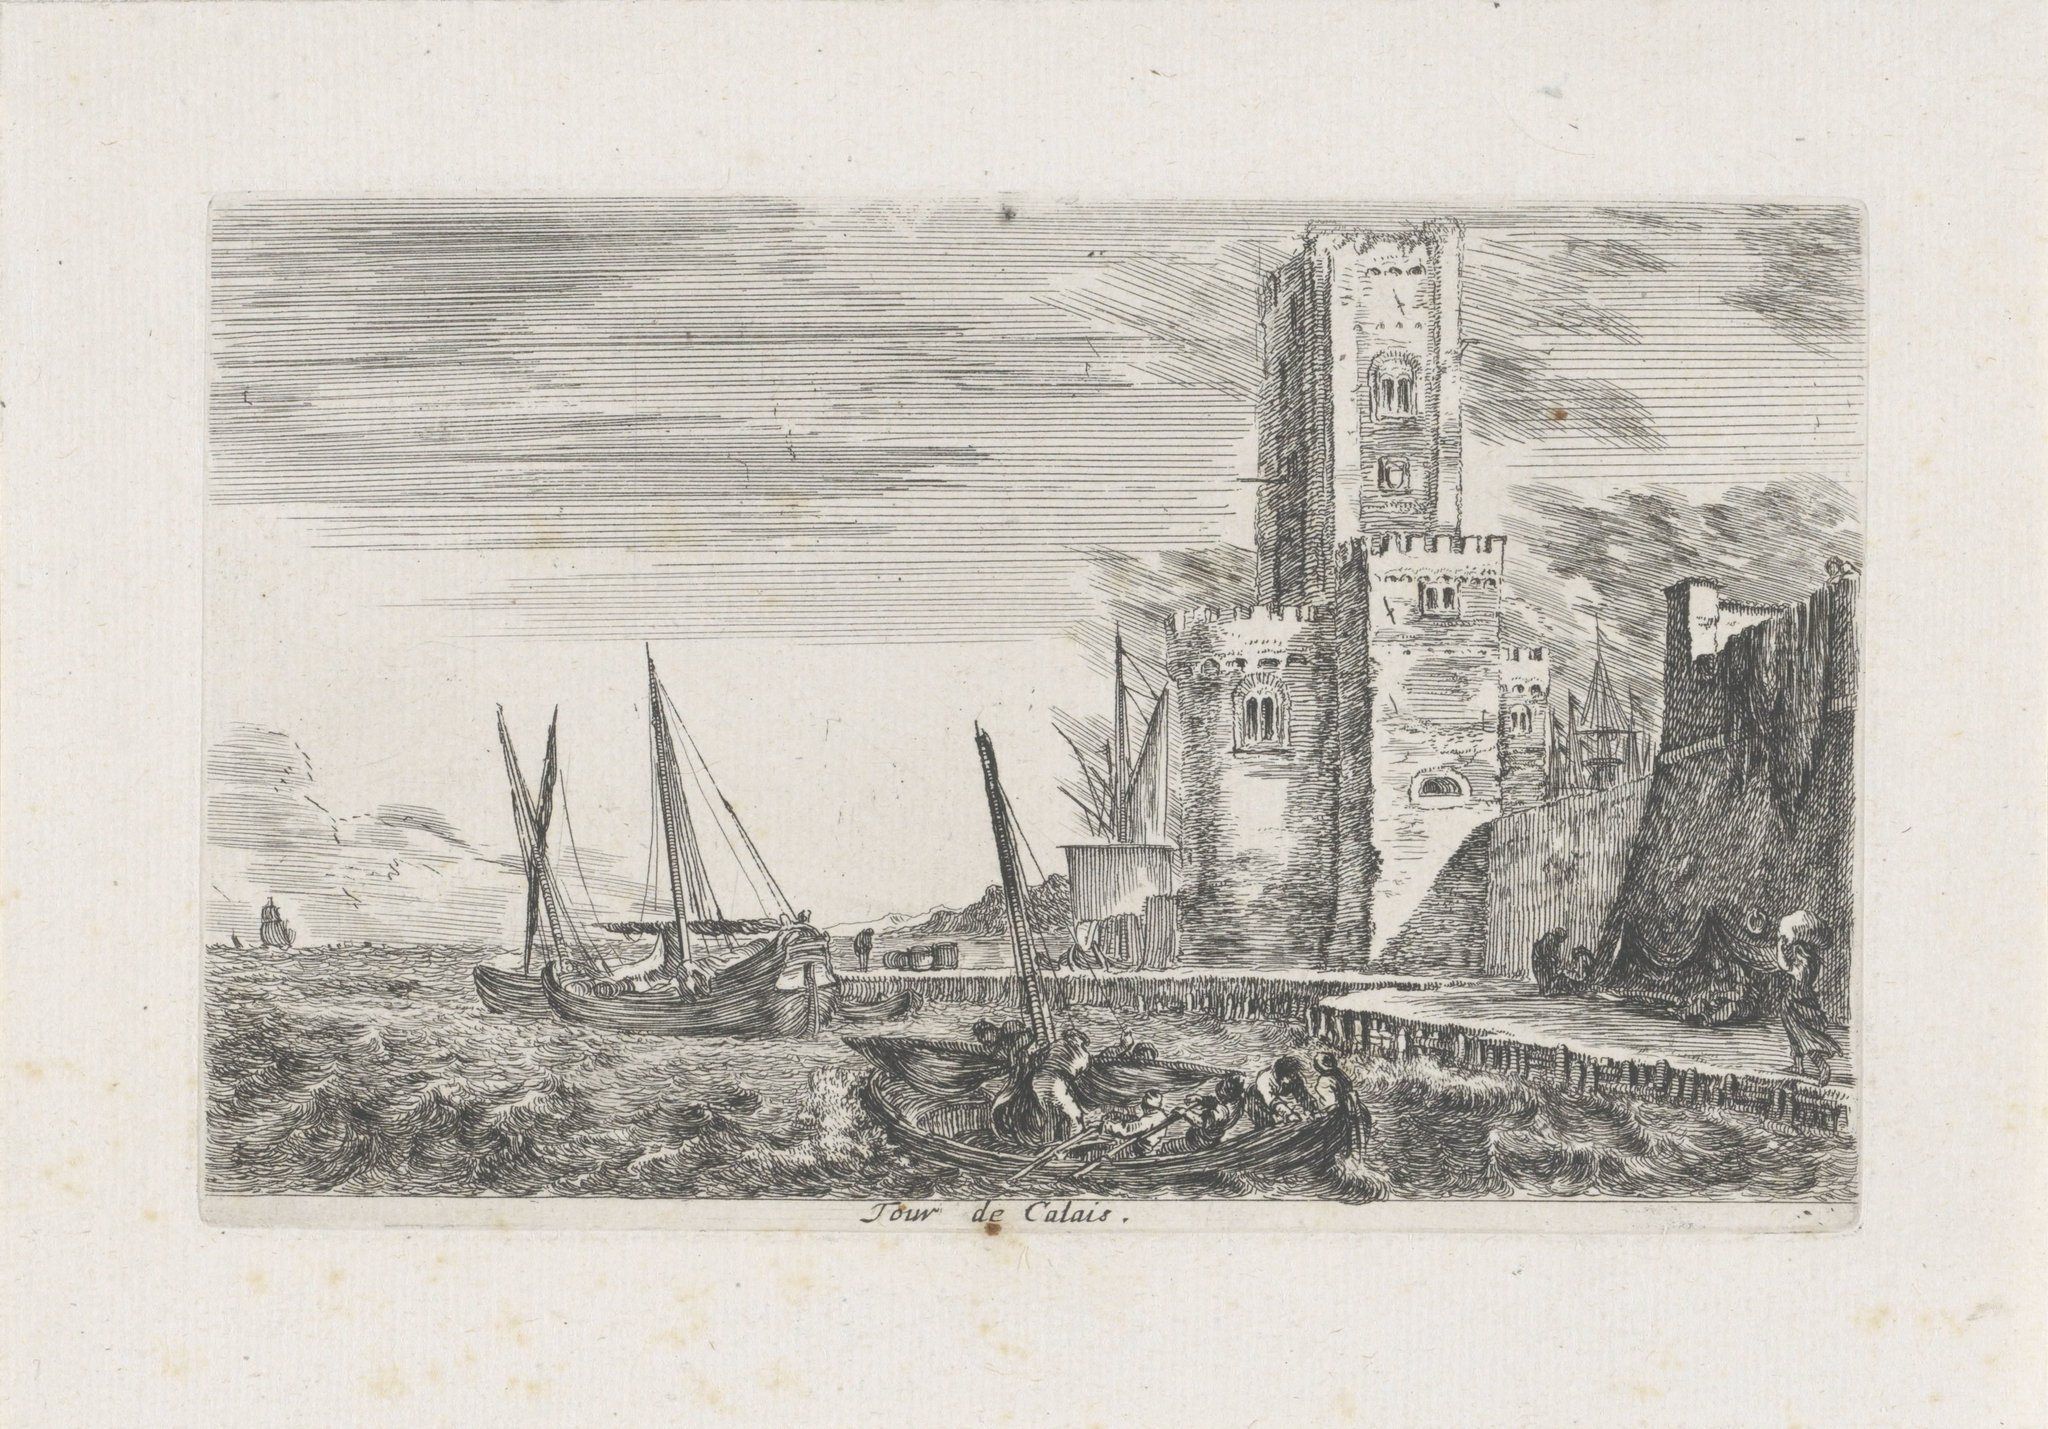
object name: print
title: Zeehavens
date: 1647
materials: paper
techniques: etching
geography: paris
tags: harbour, ships (in general)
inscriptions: collector's mark: Lugt 240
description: De haven van Calais met op de kust een muur en een toren. In de haven liggen drie zeilboten.